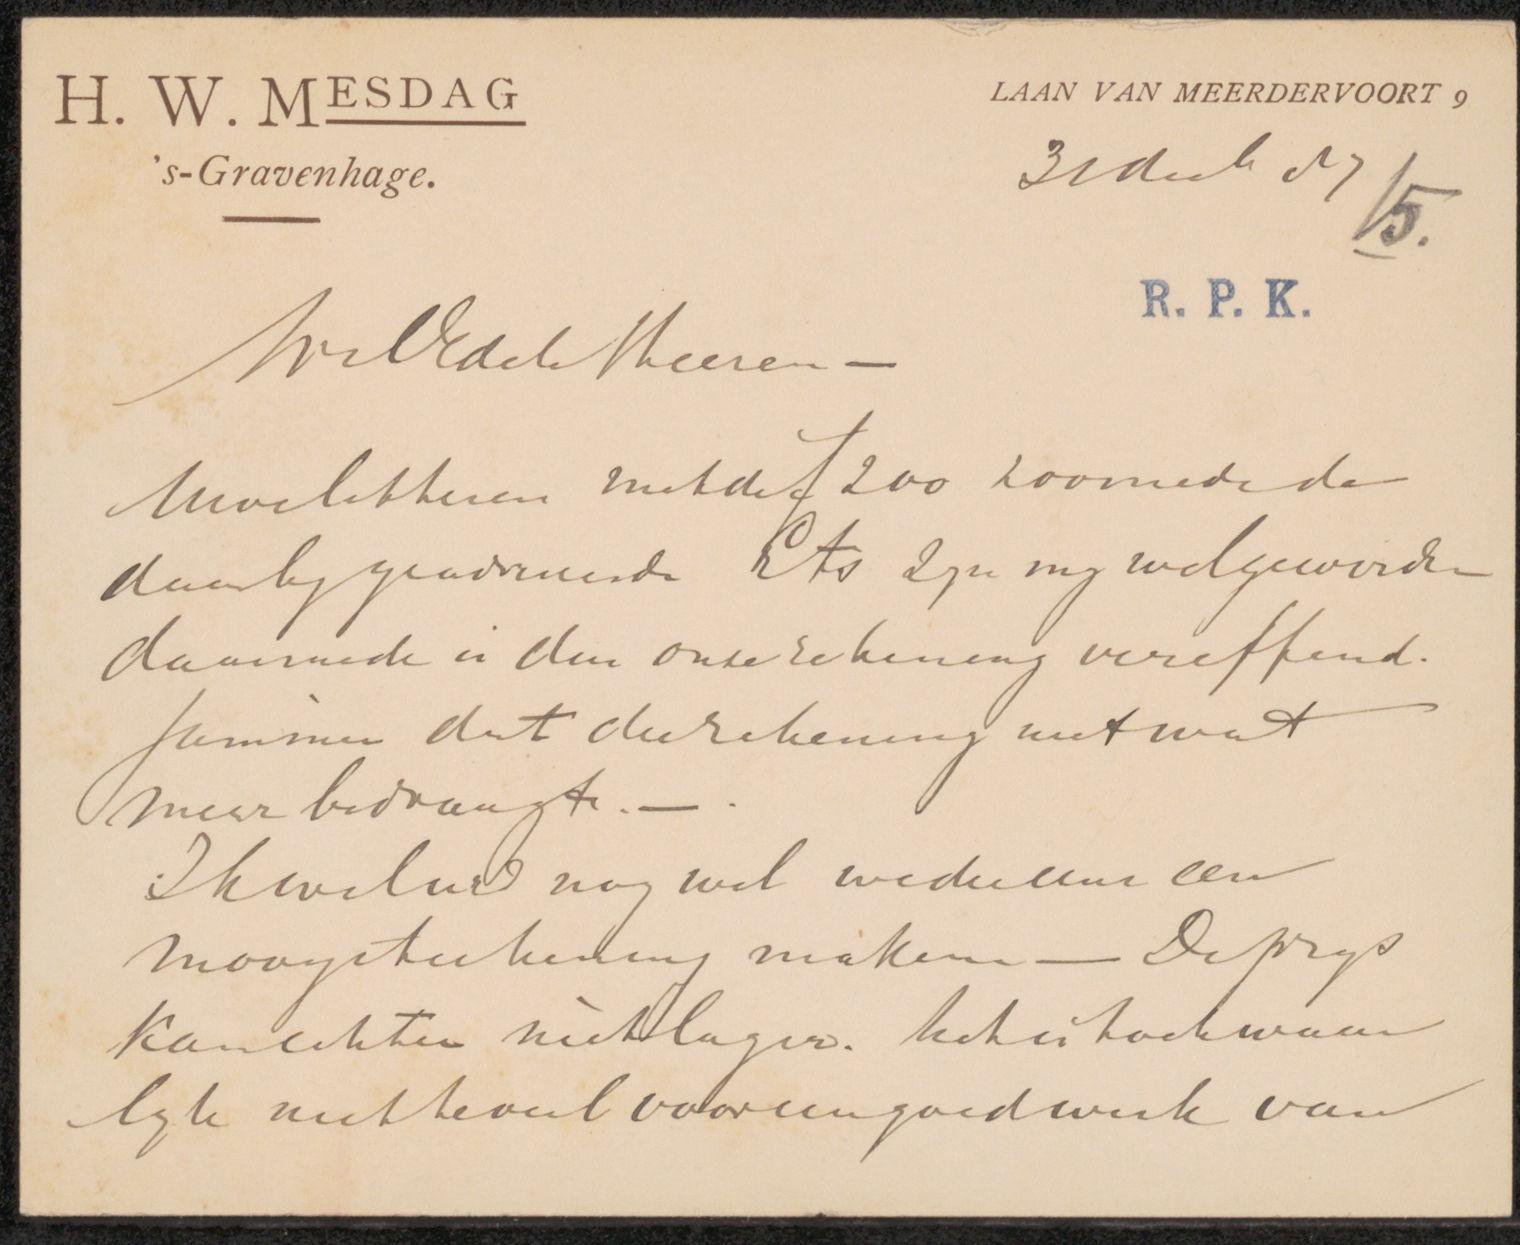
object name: letter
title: Brief aan Frans Buffa en Zonen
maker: hendrik willem mesdag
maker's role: draughtsman, painter, print maker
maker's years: 1831-1915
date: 1887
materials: cardboard, ink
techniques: pen, printing, writing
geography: the hague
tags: publisher, art trade, art shop, drawing, the graphic arts, money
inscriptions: collector's mark: Lugt 2233